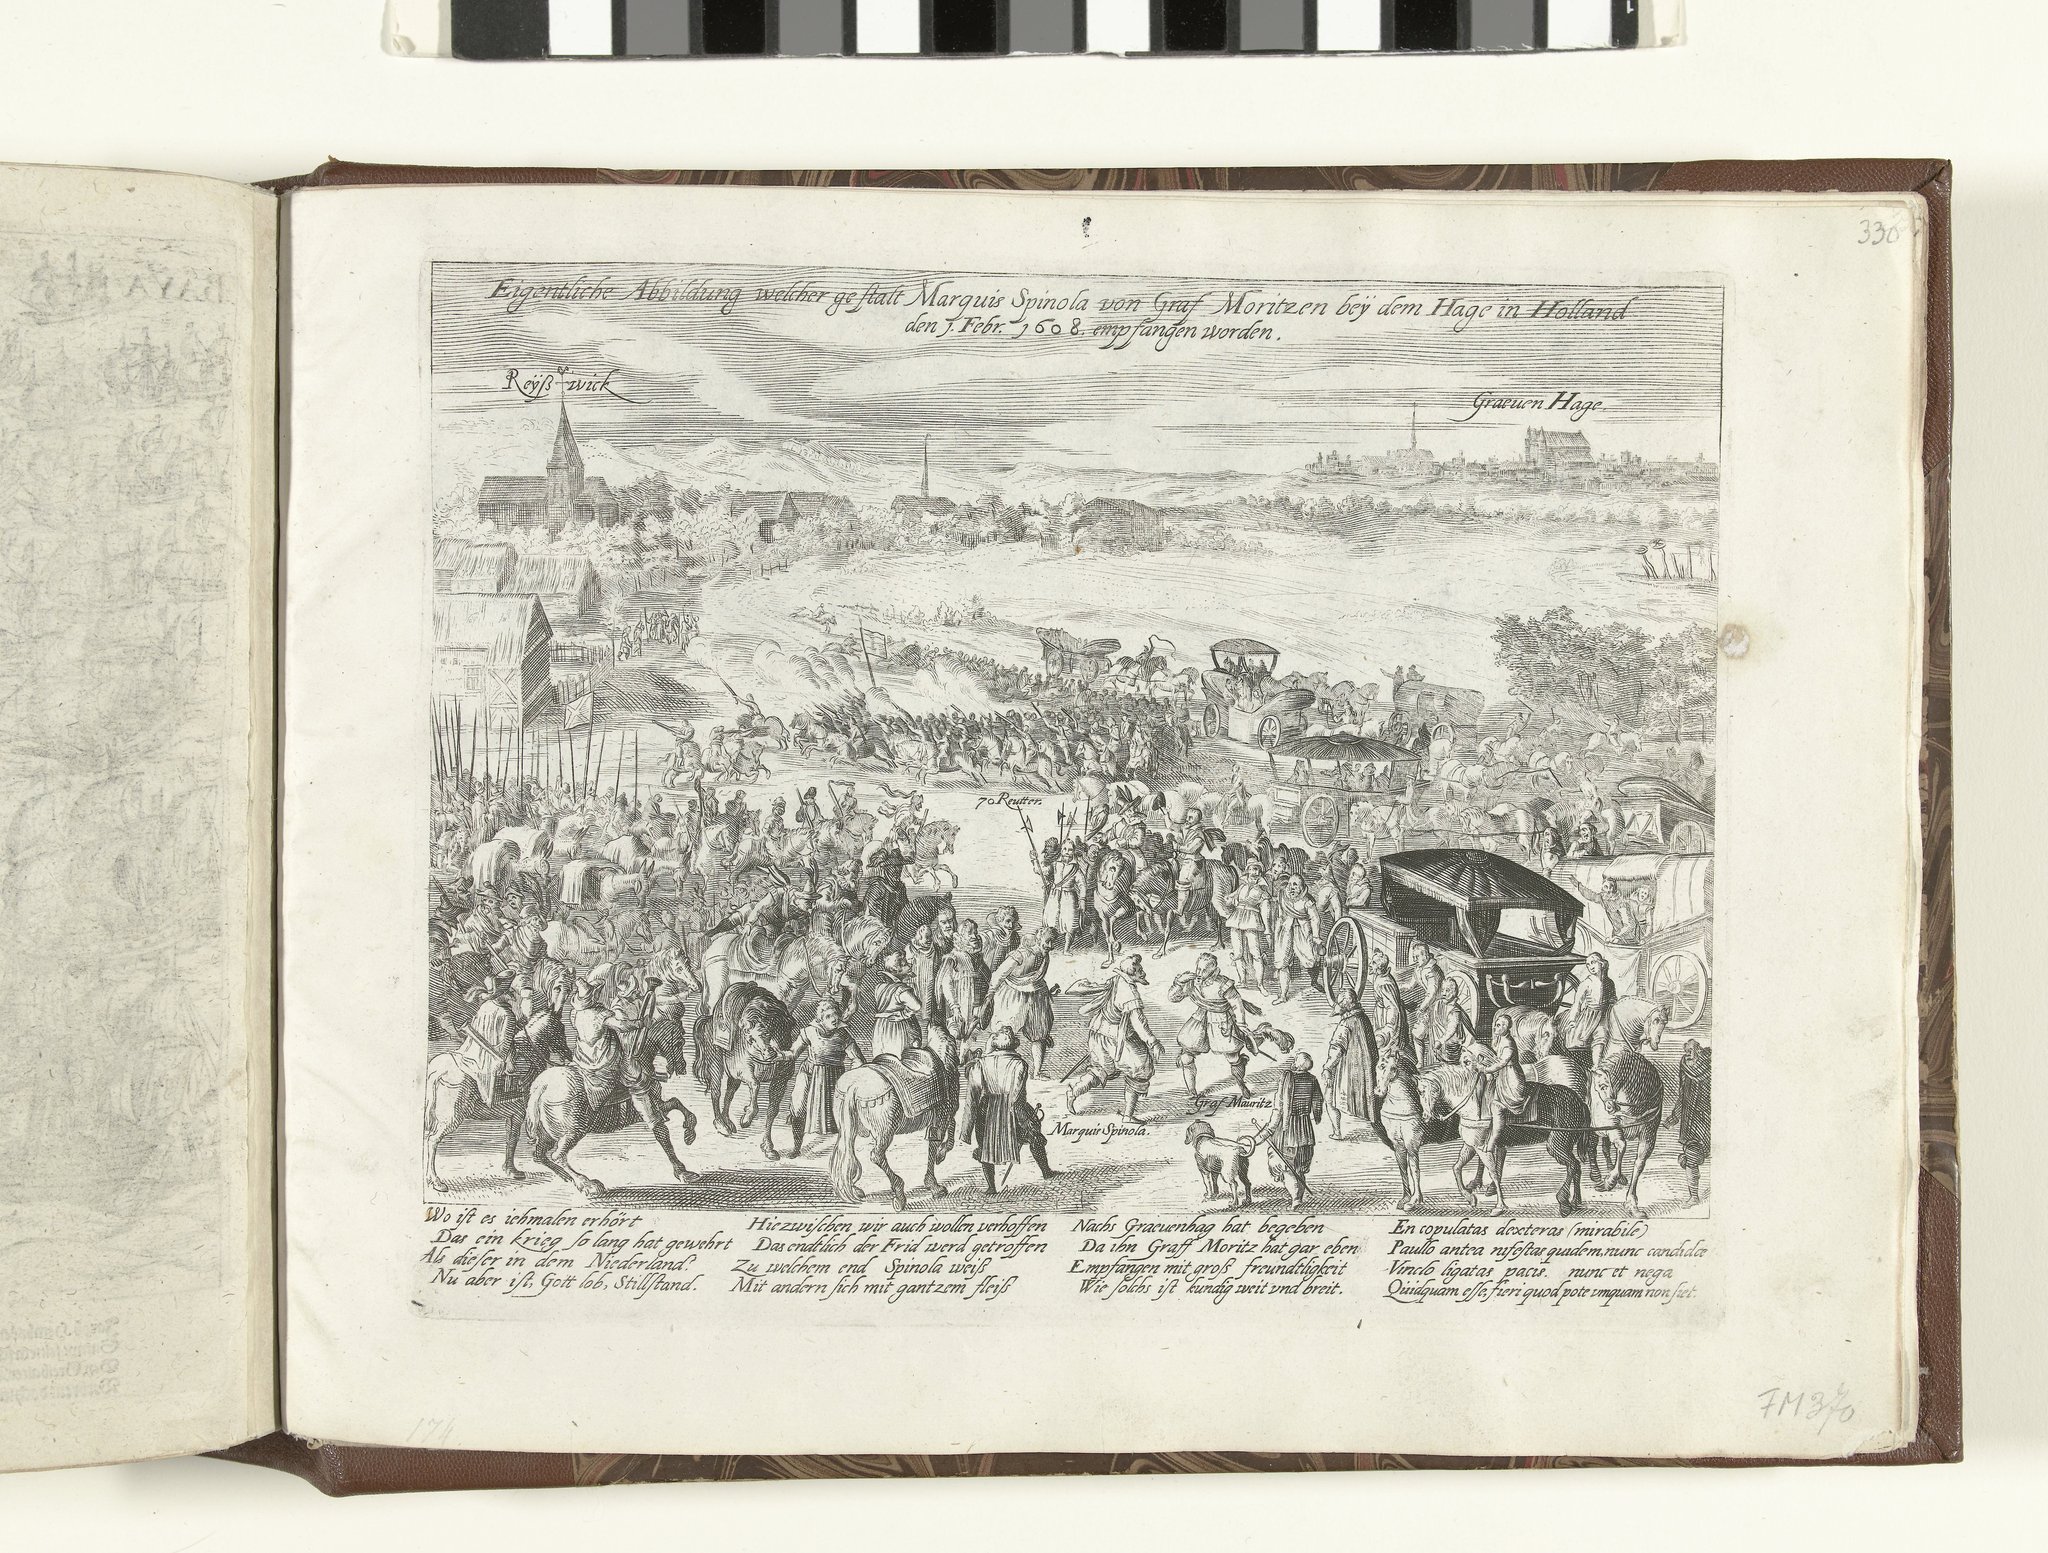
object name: print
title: Prince Maurice Receives Spinola and his Retinue at Rijswijk before Peace Talks on 1 February 1608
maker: frans hogenberg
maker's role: print maker, publisher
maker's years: 1538-1590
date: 1608-1610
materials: paper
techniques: engraving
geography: cologne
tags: the hague, maurice (prince of orange), peace negotiations, meeting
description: Prins Maurits ontvangt Spinola en zijn gevolg te Rijswijk voor vredesbesprekingen, 1 februari 1608. In de verte Den Haag. Met onderschrift van 12 regels in het Duits en 4 regels in het Latijn. Ongenummerd.